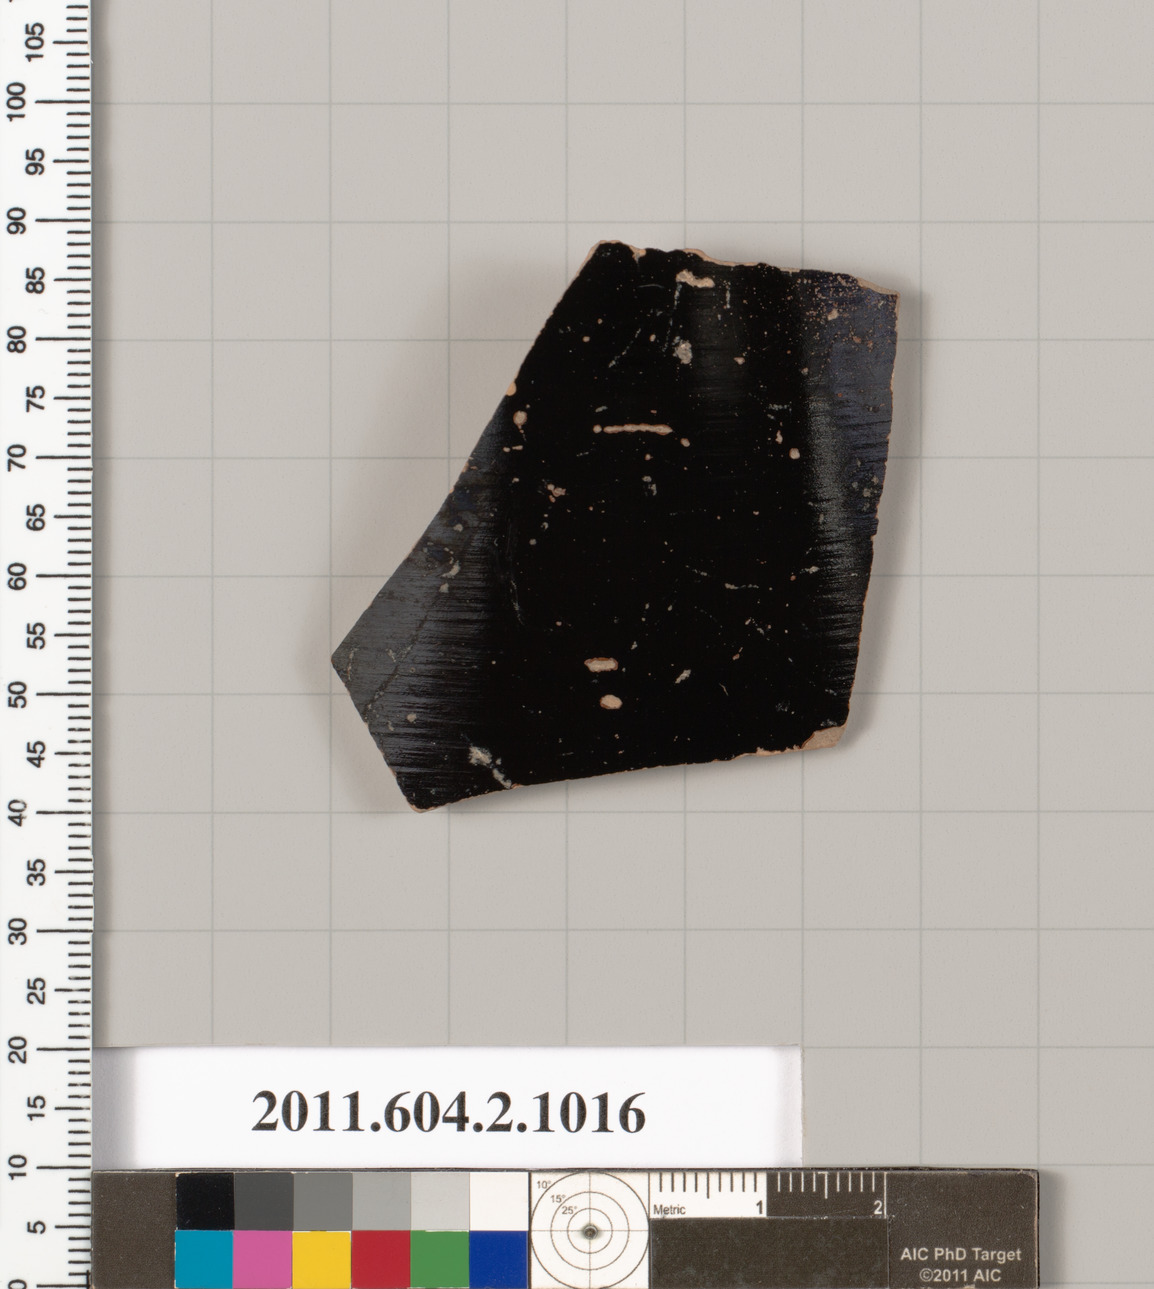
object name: oinochoe fragment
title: Terracotta fragment of an oinochoe (jug)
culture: greek, attic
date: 475-425 BCE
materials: terracotta